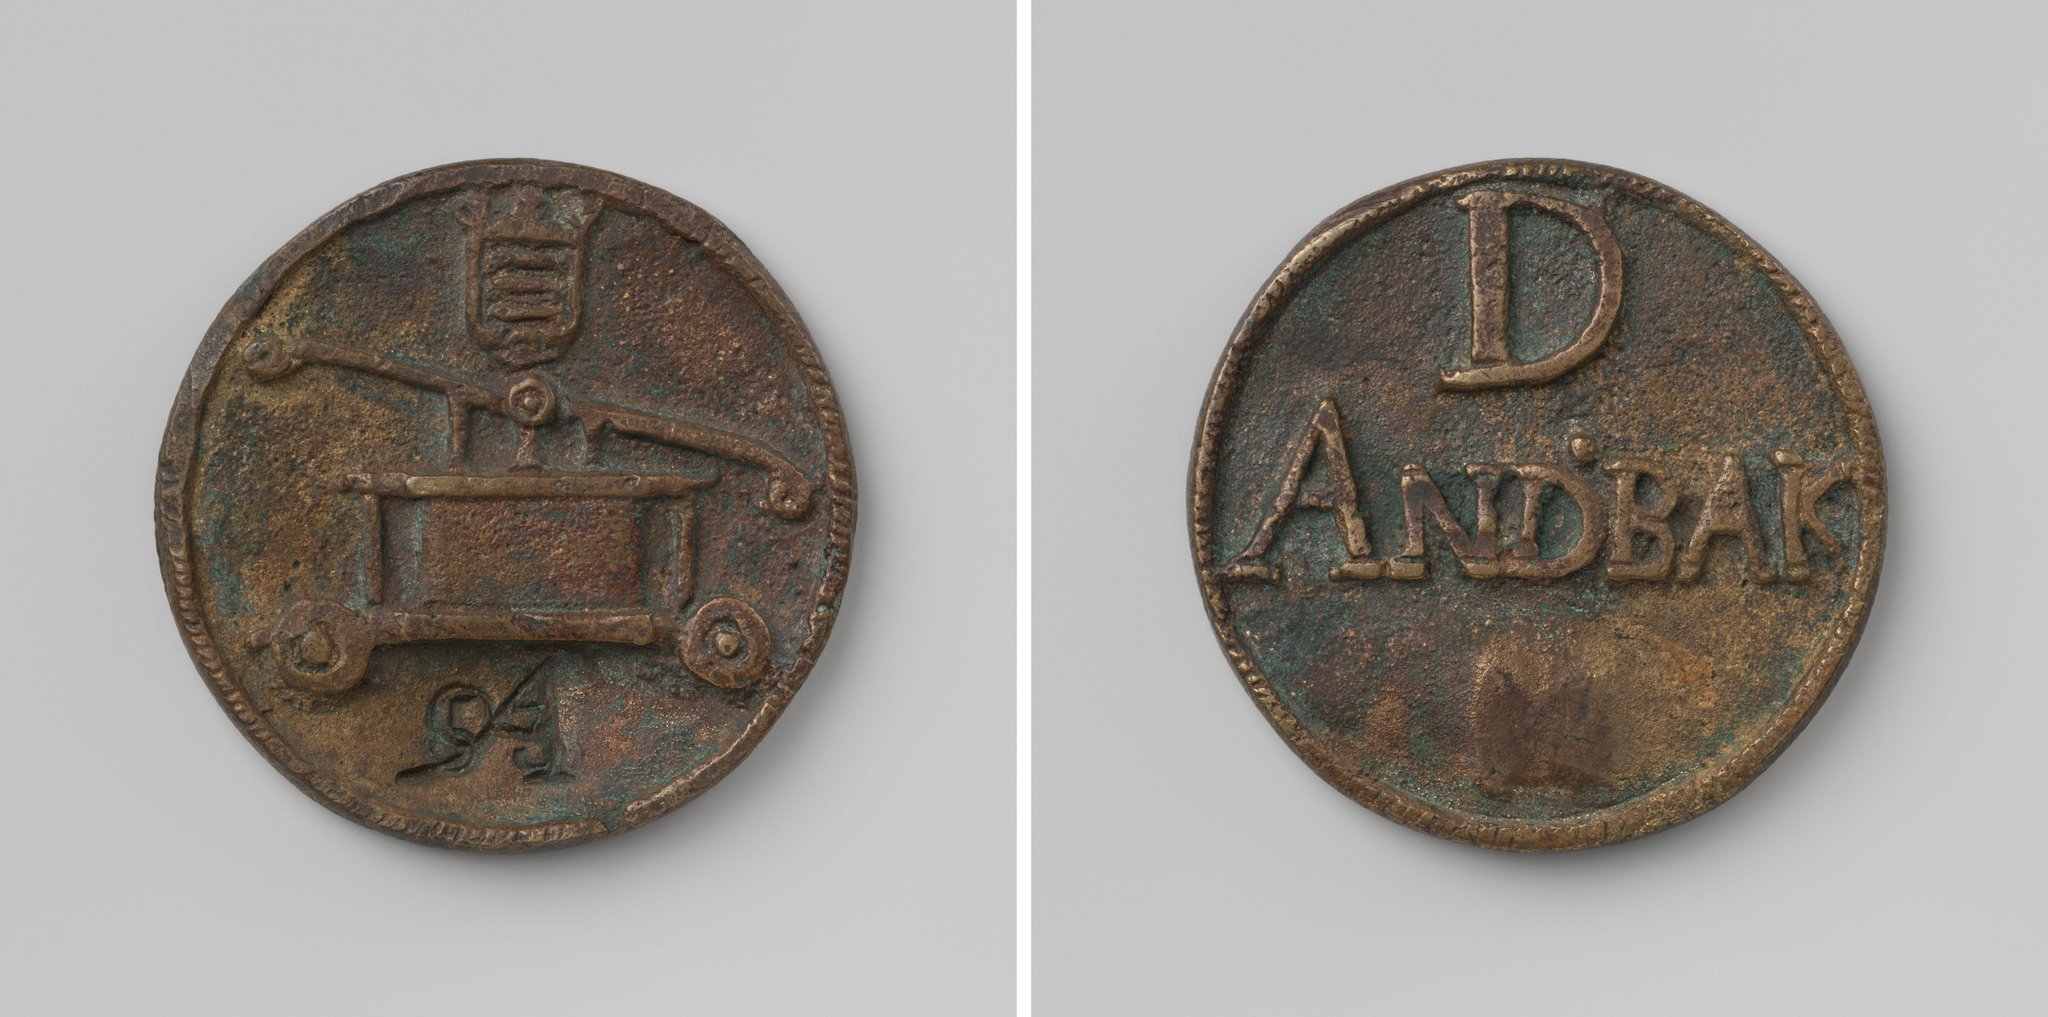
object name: fire engine medal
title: Enkhuizen, brandspuitpenning van de man aan de bak van spuit D met no. 94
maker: Anonymous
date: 1680-1800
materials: brass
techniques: casting, engraving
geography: enkhuizen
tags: enkhuizen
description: Messing penning. Voorzijde: brandspuit onder gekroond wapenschild boven cijfer 94. Keerzijde: opschrift